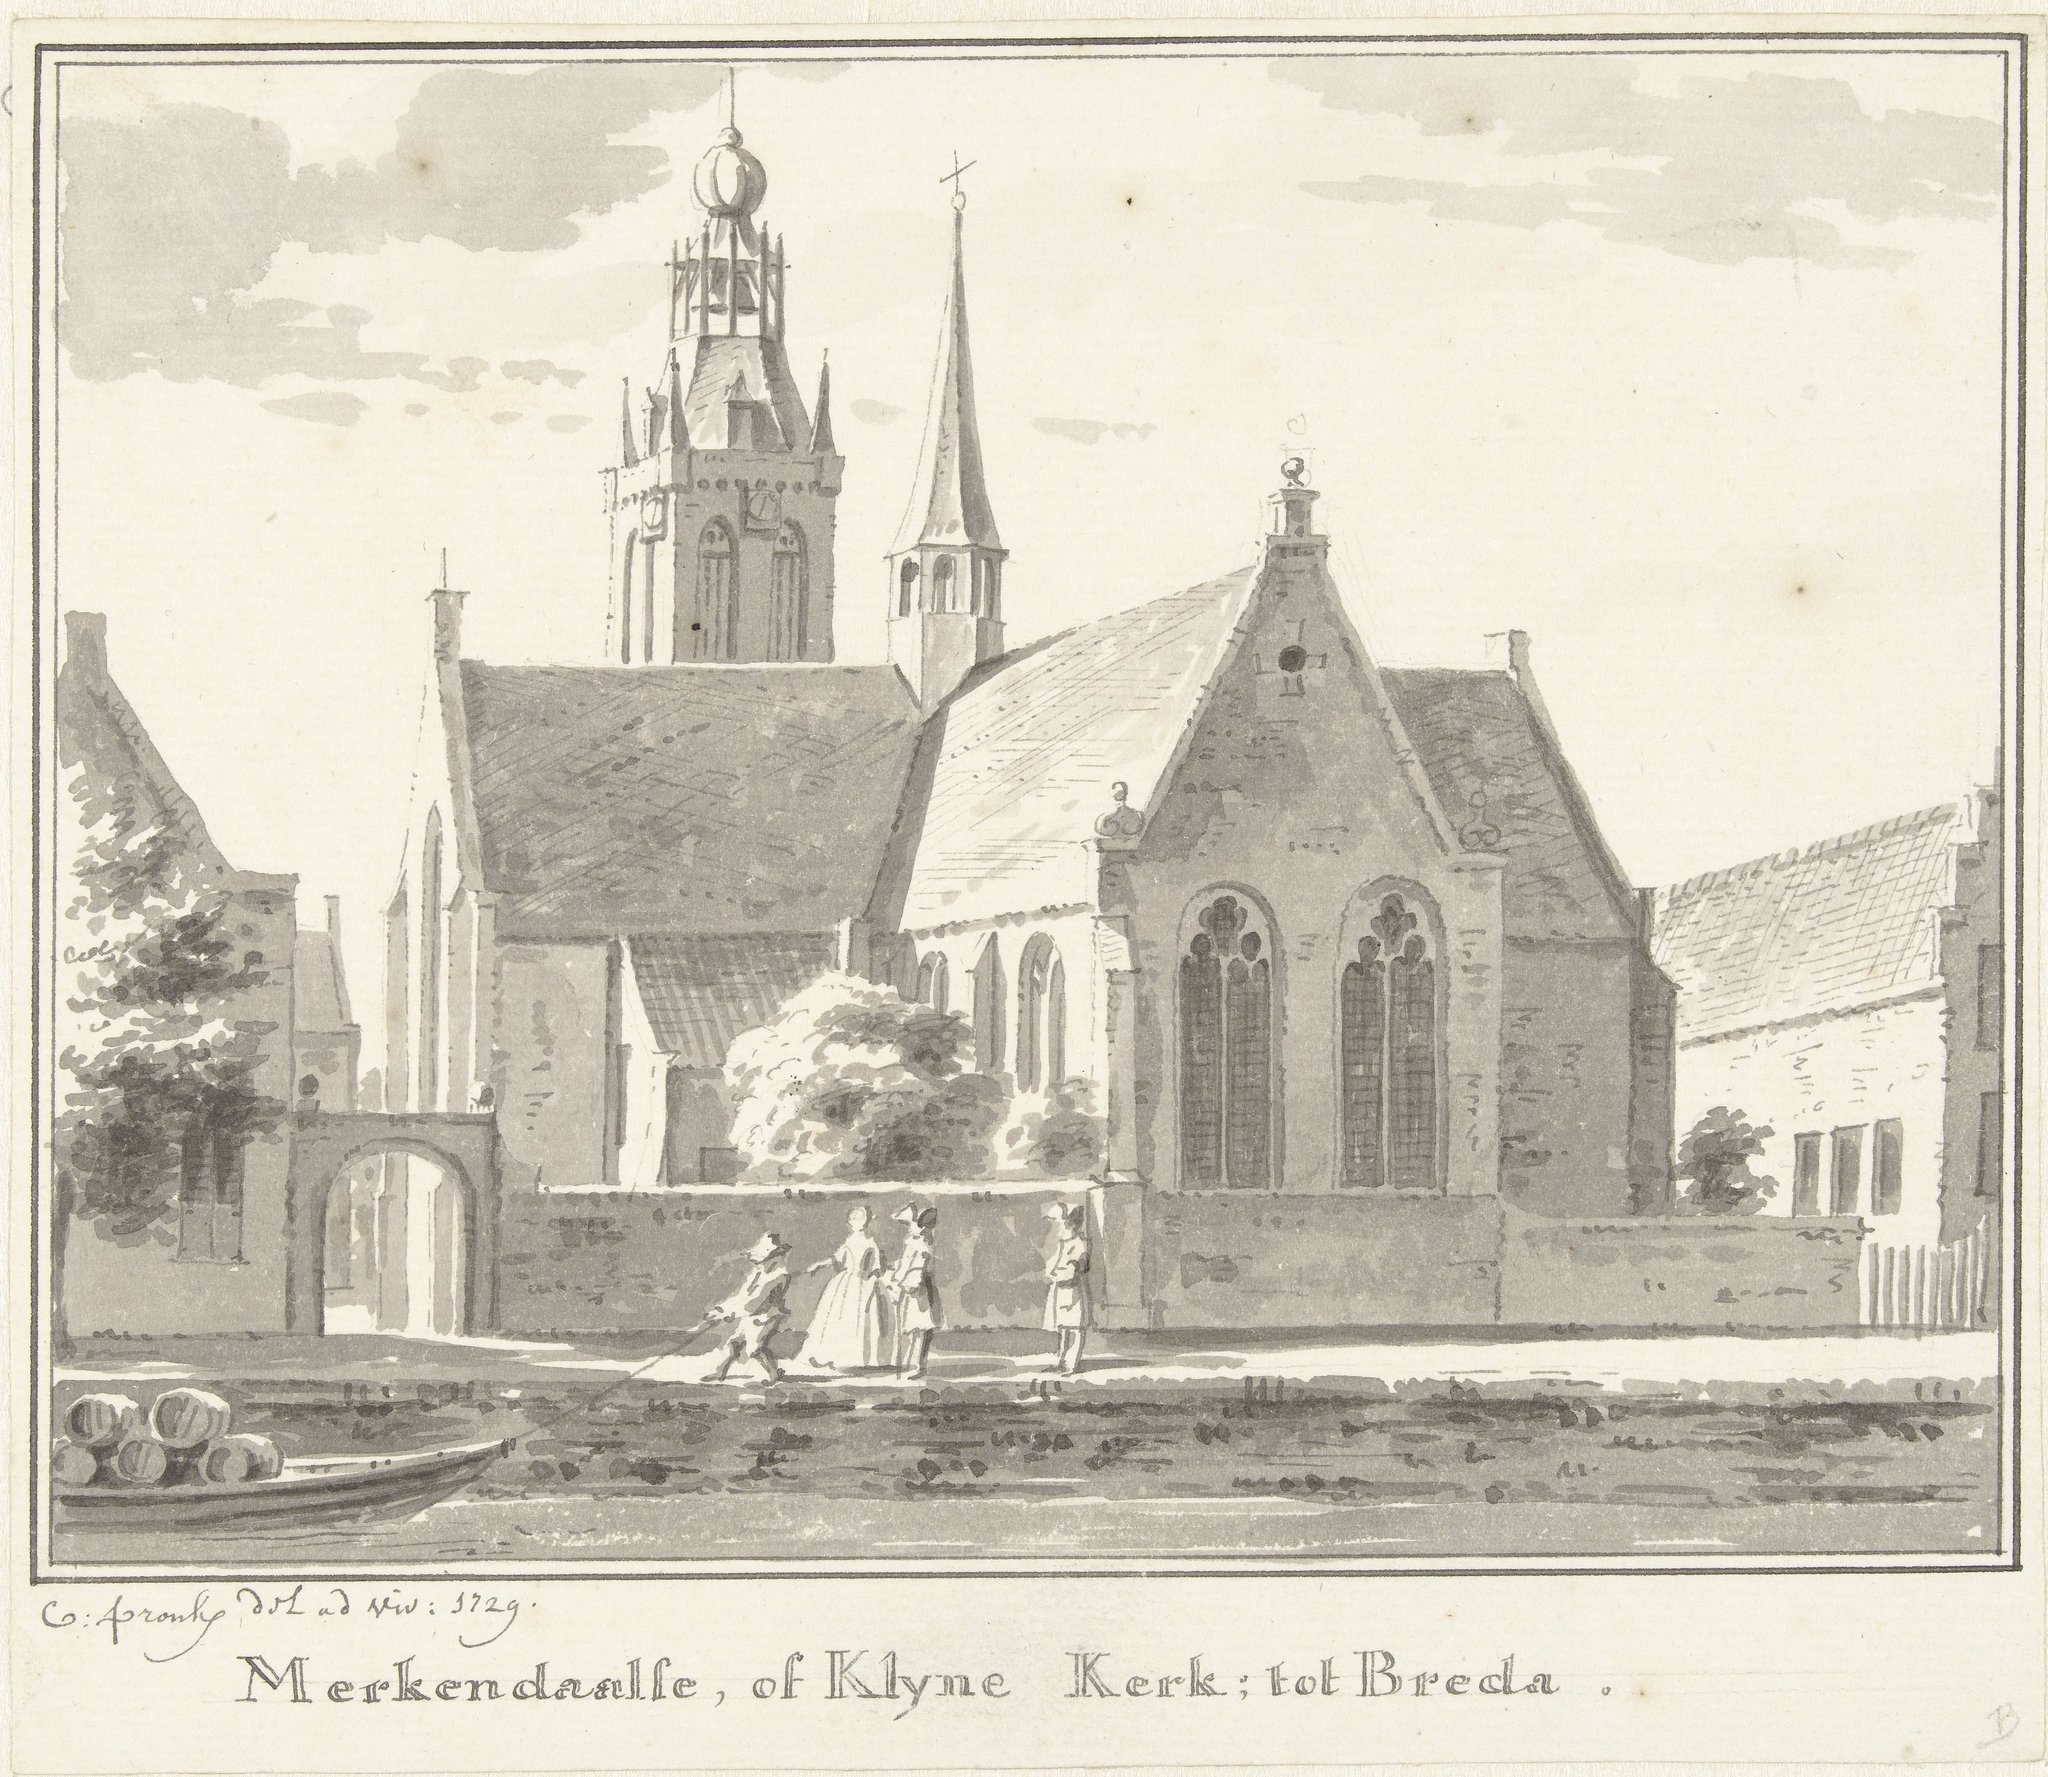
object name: drawing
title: De Merkendaalse of kleine kerk te Breda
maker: cornelis pronk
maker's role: draughtsman, painter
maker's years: 1691-1759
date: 1729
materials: ink, paper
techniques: brush, pen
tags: church (exterior)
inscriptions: caption: ‘C: pronk del ad viv: 1729 / Merkendaalse, of Klyne Kerk; tot Breda’